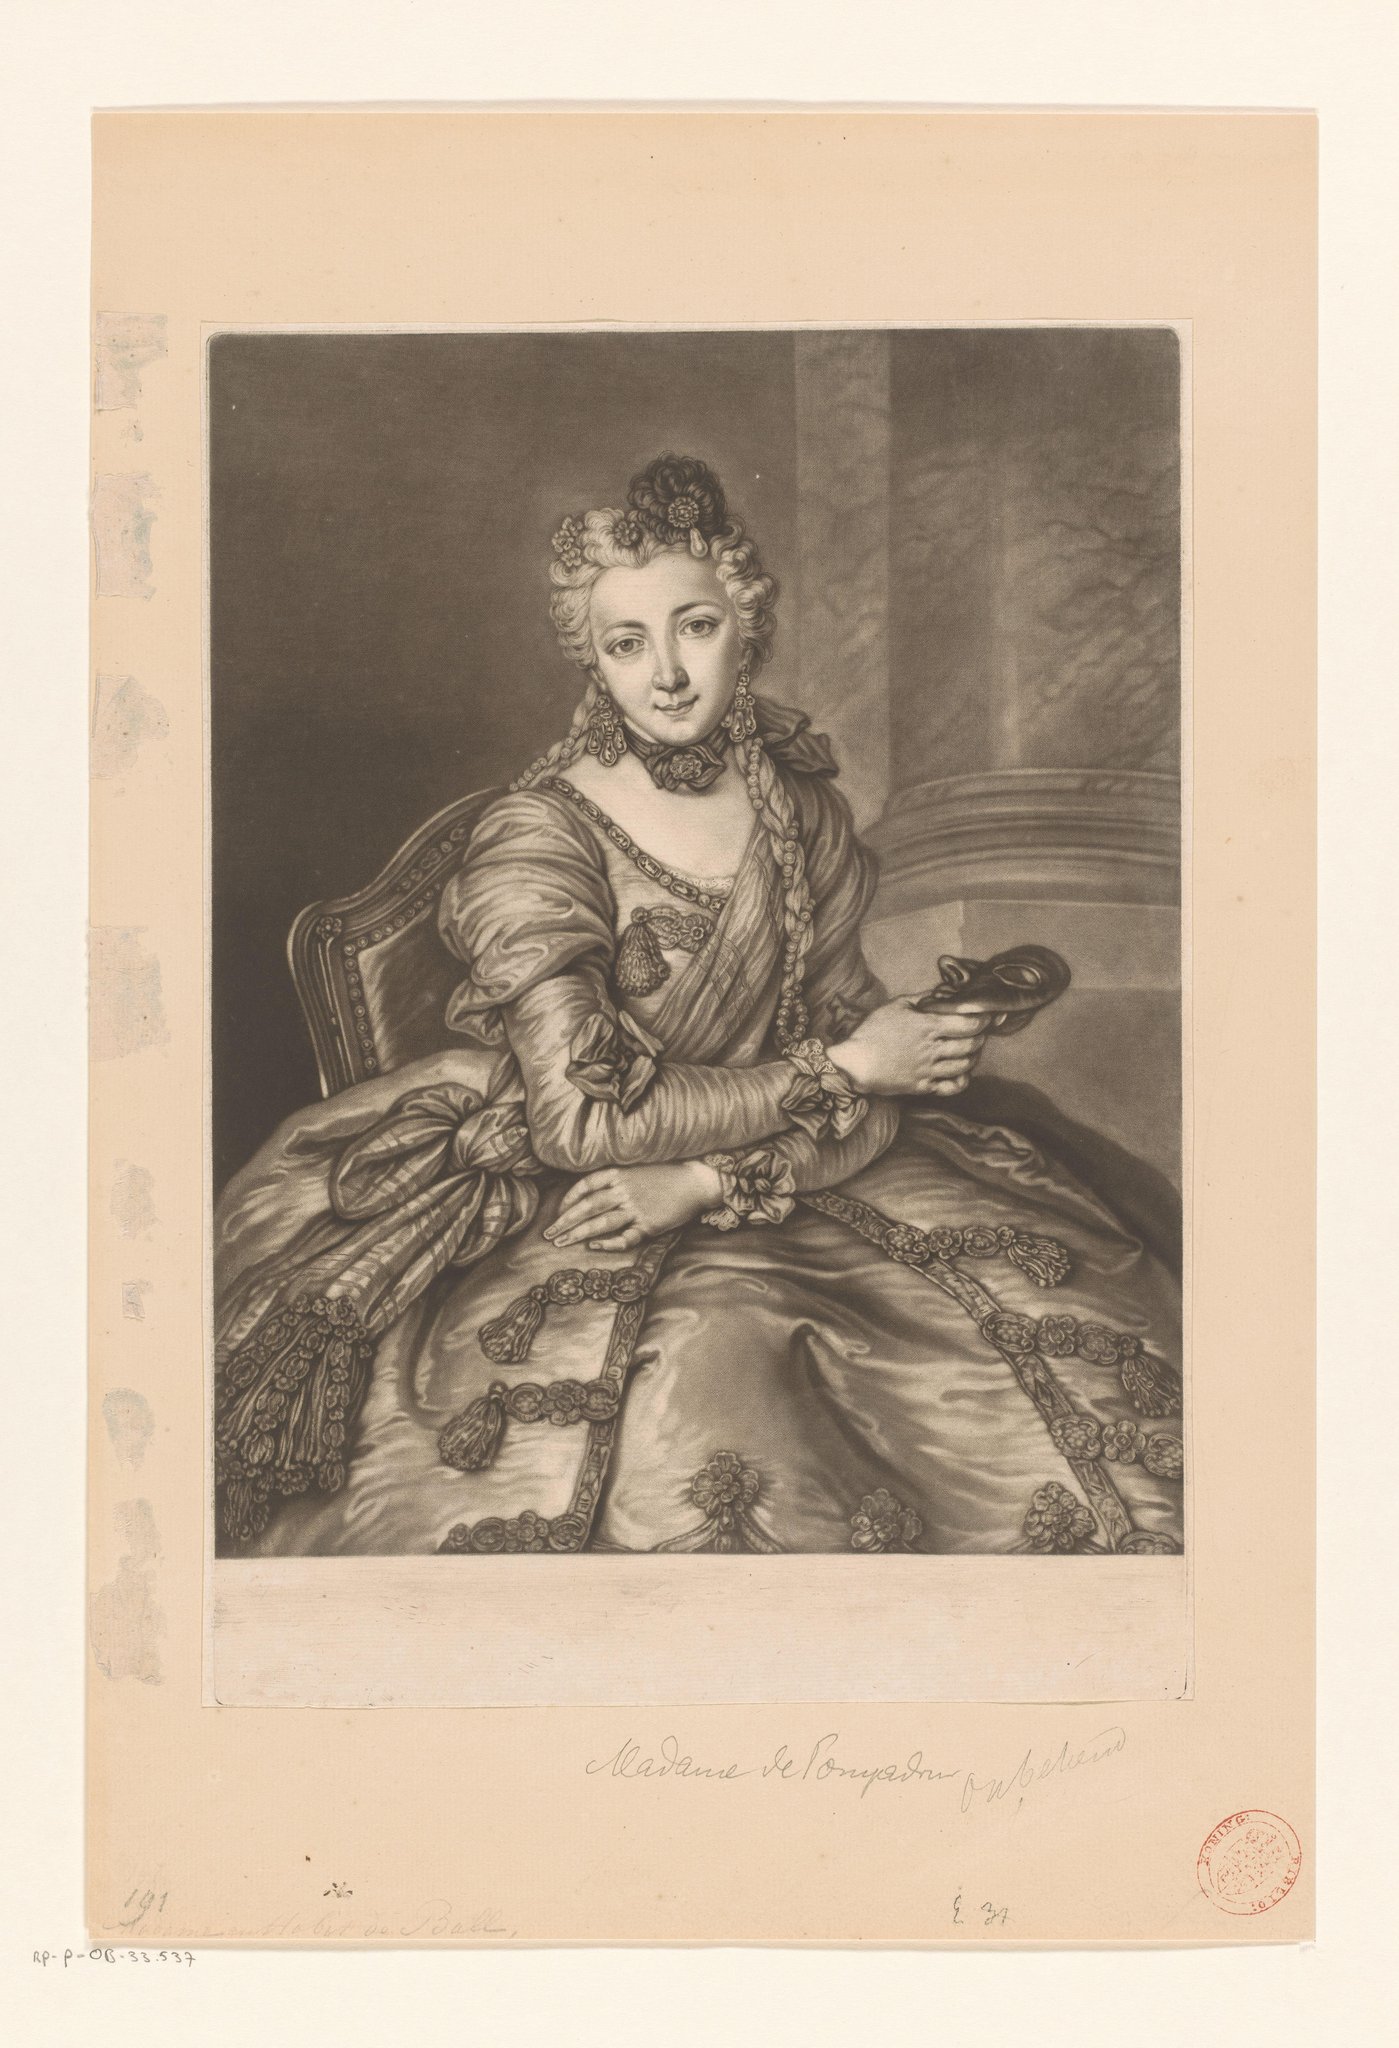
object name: print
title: Portret van Madame de Mouchy, vermoedelijk Anne d'Arpajon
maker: richard purcell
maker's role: print maker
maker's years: 1736-1766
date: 1770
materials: paper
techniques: mezzotint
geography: england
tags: paris, mask, historical persons - bb - woman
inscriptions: collector's mark: Lugt 240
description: Het portret wordt soms geïdentificeerd als dat van Madame de Pompadour, maar is vermoedelijk van een Madame de Mouchy. Met Madame de Mouchy wordt vermoedelijk Anne d'Arpajon bedoeld. Zie ook Chaloner Smith, 1880 en RP-P-OB-74.385.